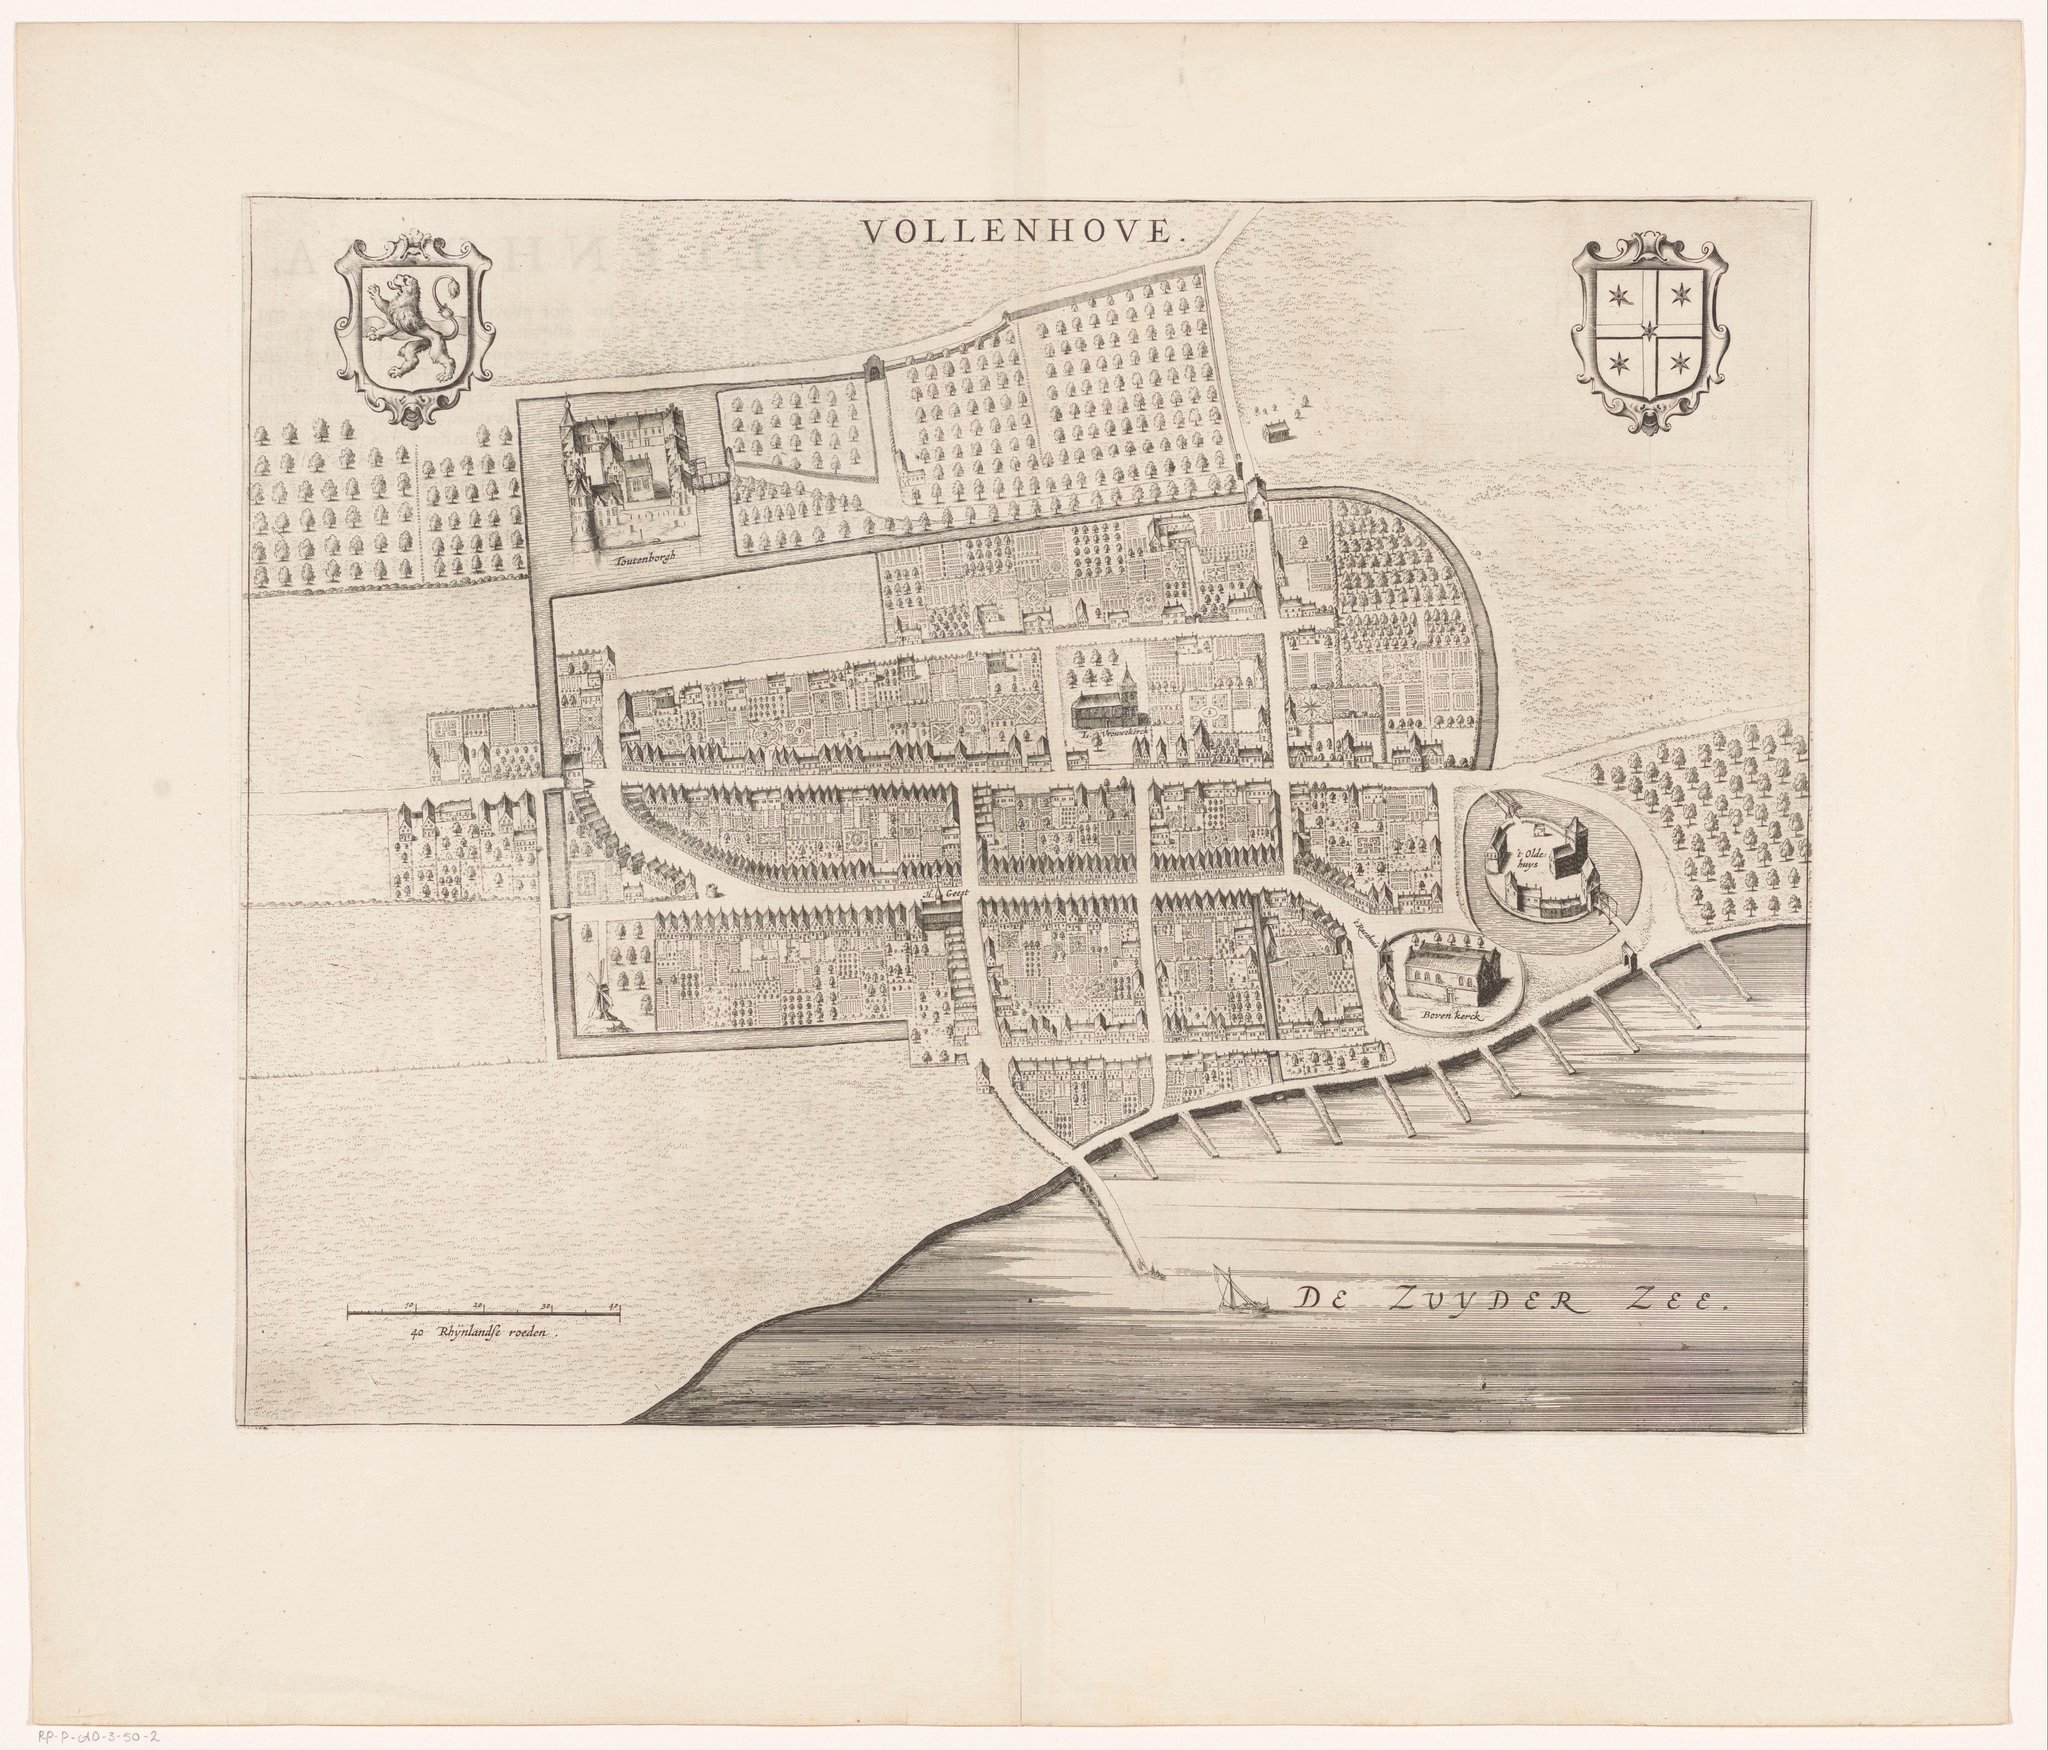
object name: print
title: Vollenhove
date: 1652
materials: paper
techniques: engraving, etching, letterpress printing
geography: amsterdam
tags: coat of arms (as symbol of the state, etc.), maps of cities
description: Plattegrond in vogelvluchtperspectief. Linksboven het wapen van Overijssel. Linksonder een schaalstok: 40 Rhijnlandse roeden. Rechtsboven het wapen van Vollenhove. Op verso Latijnse tekst.